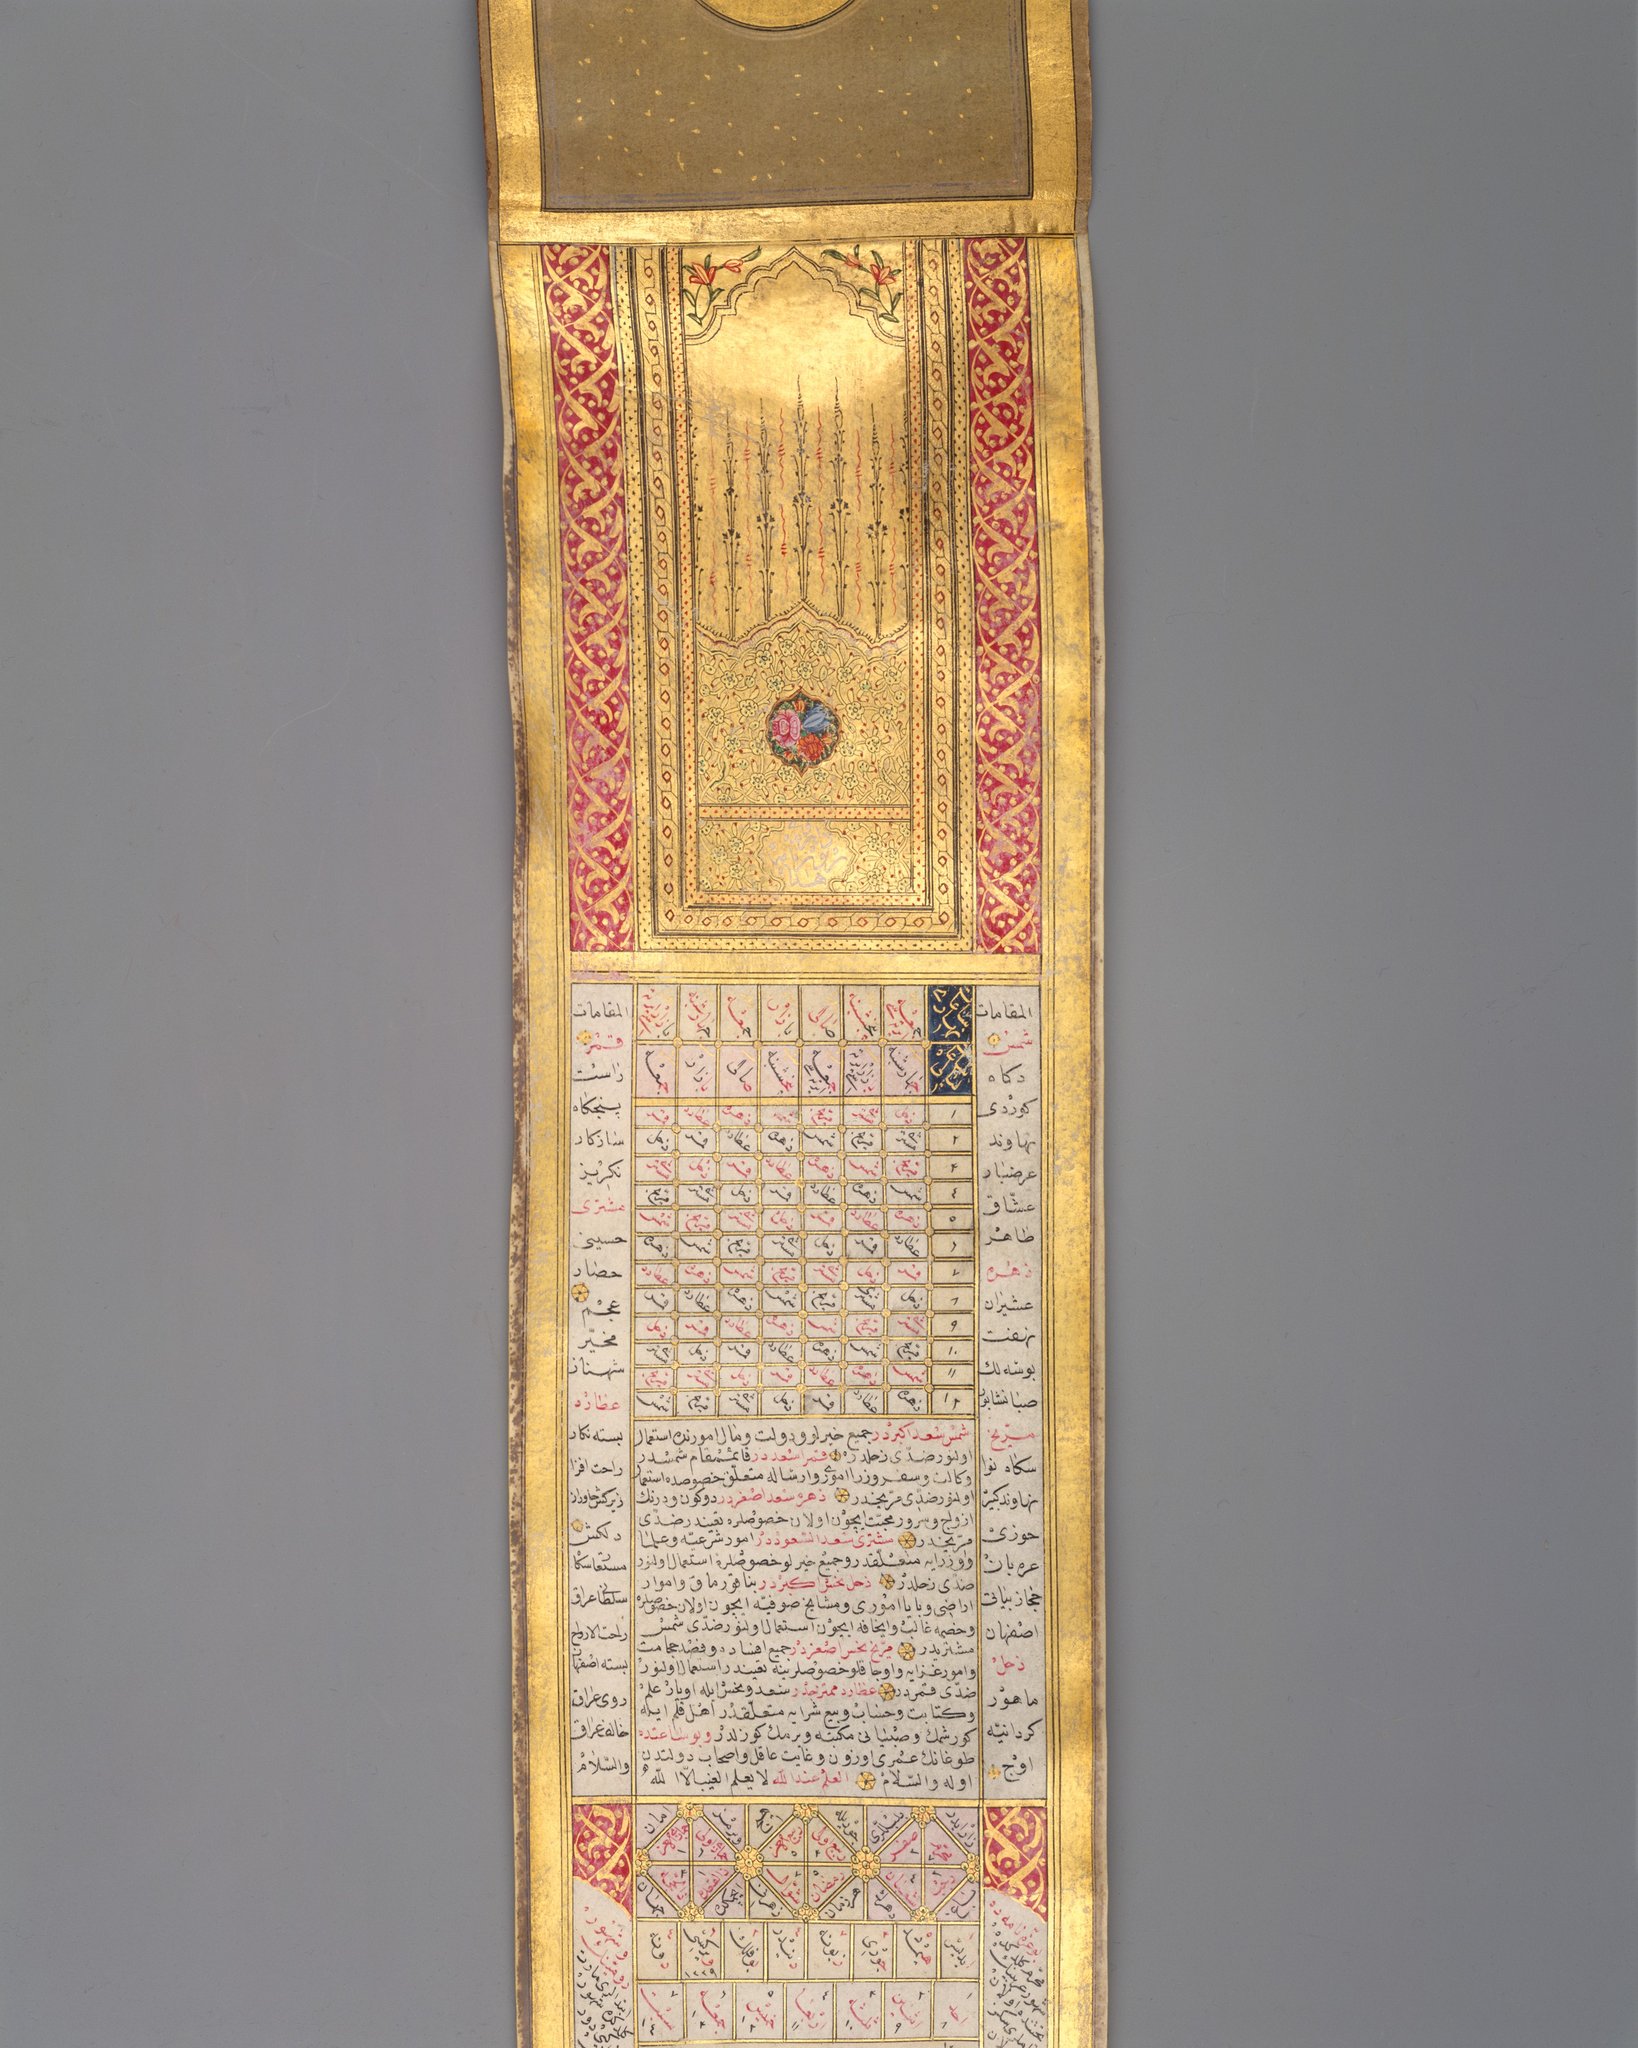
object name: scroll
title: Calendar-Almanac in Scroll Form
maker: katib muhammad ma'ruf na'ili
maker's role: calligrapher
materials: gold, ink, parchment, watercolor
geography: turkey